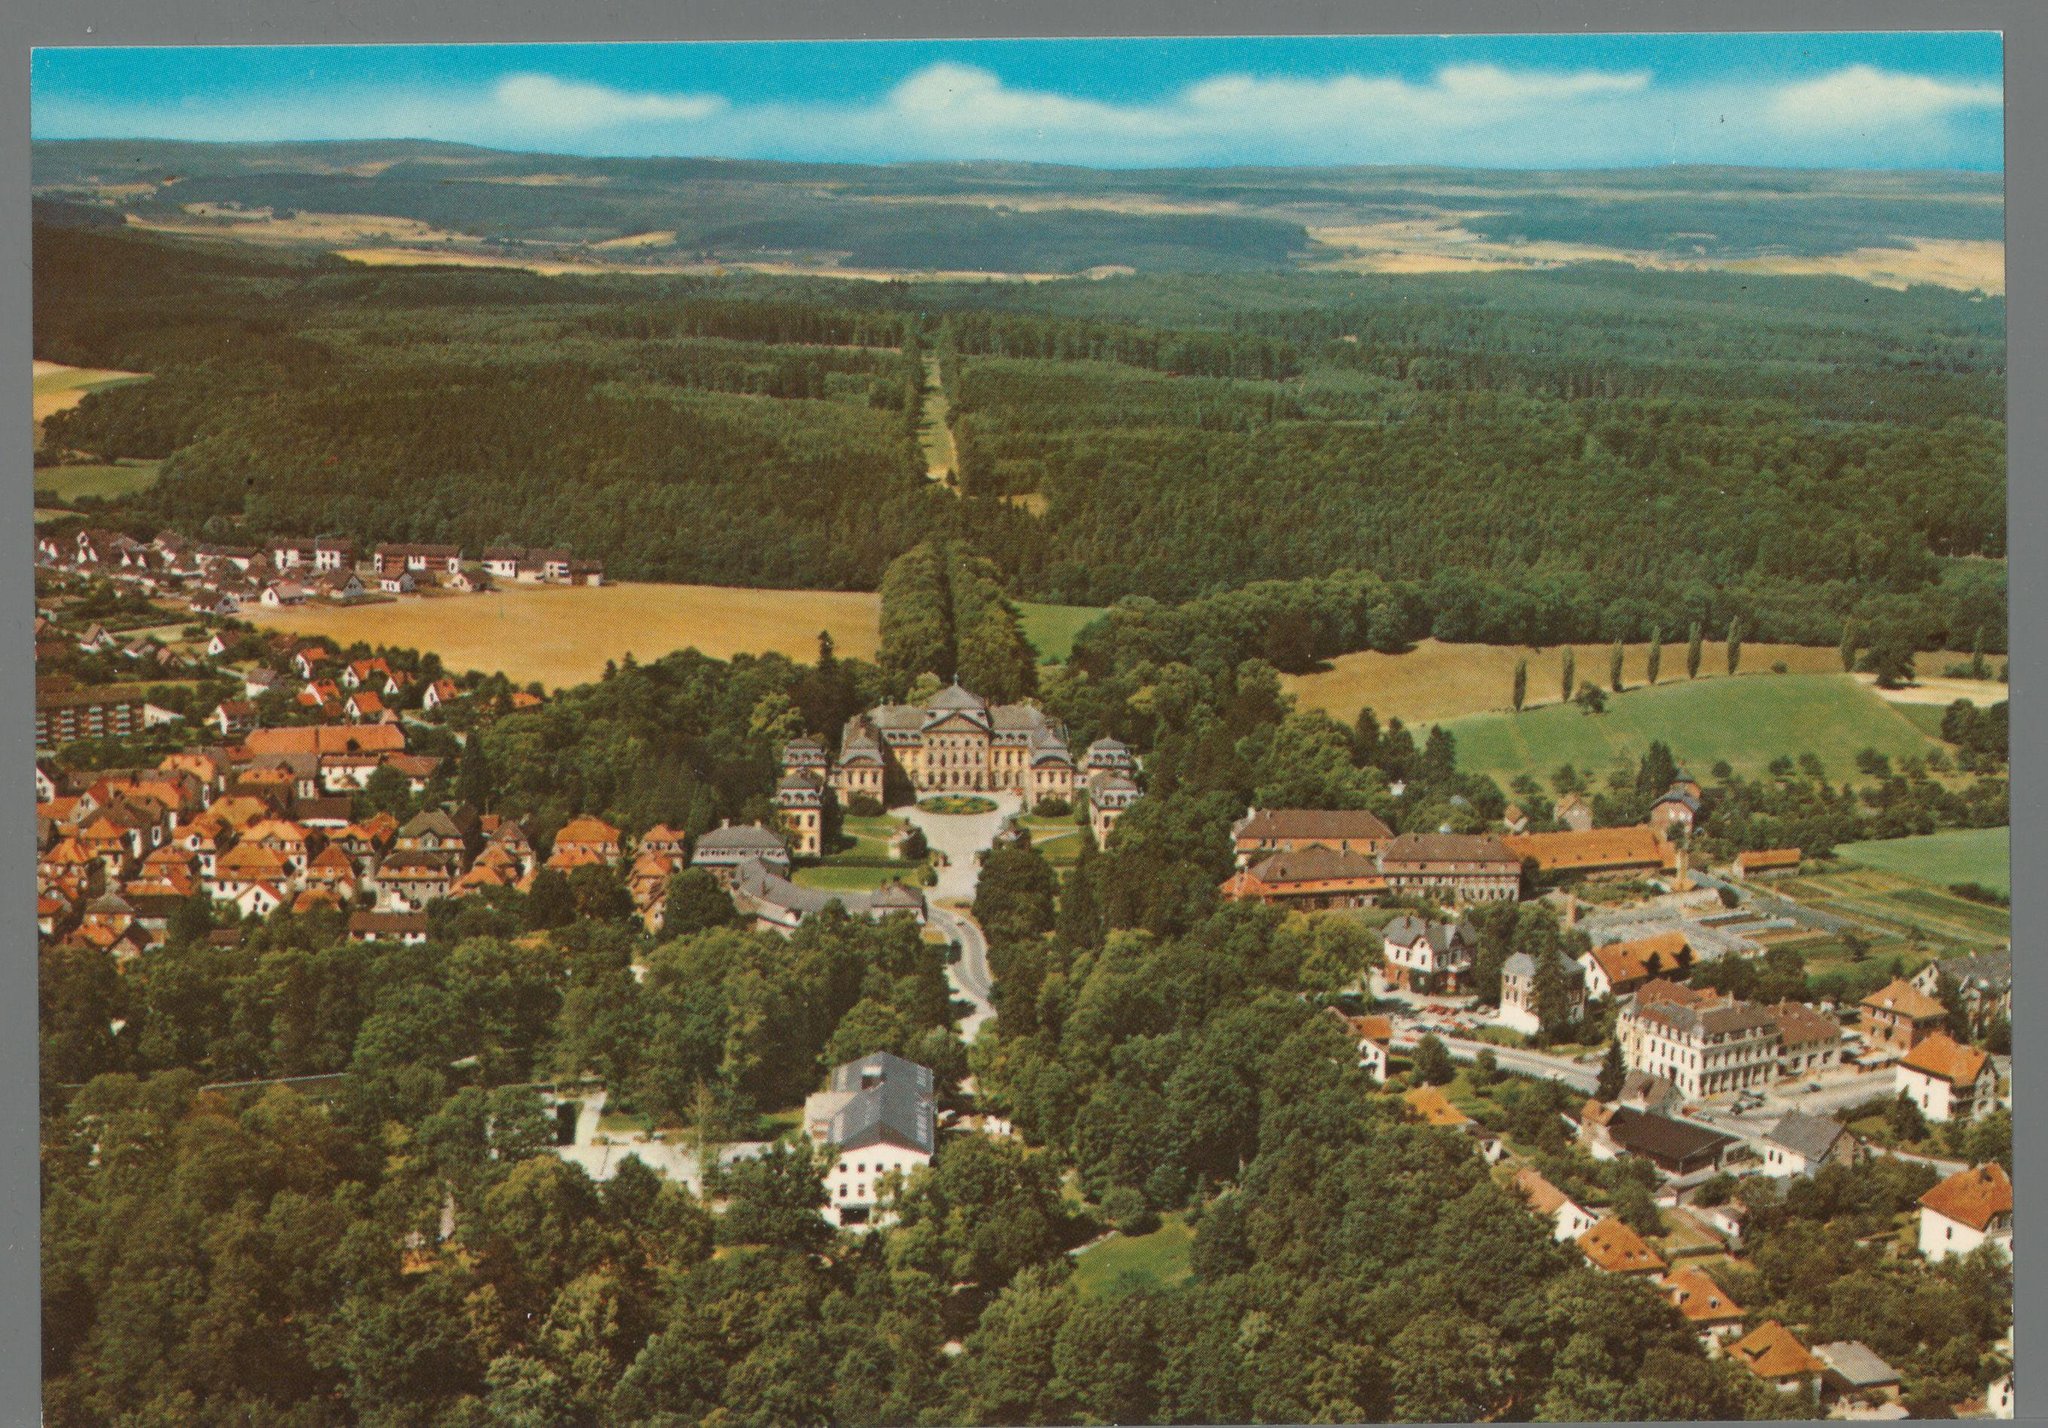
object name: photomechanical print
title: Arolsen im Ferienland Waldeck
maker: Anonymous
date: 1970-1990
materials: cardboard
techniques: offset printed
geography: bad arolsen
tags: city-view in general; 'veduta', castle, watering-place, spa